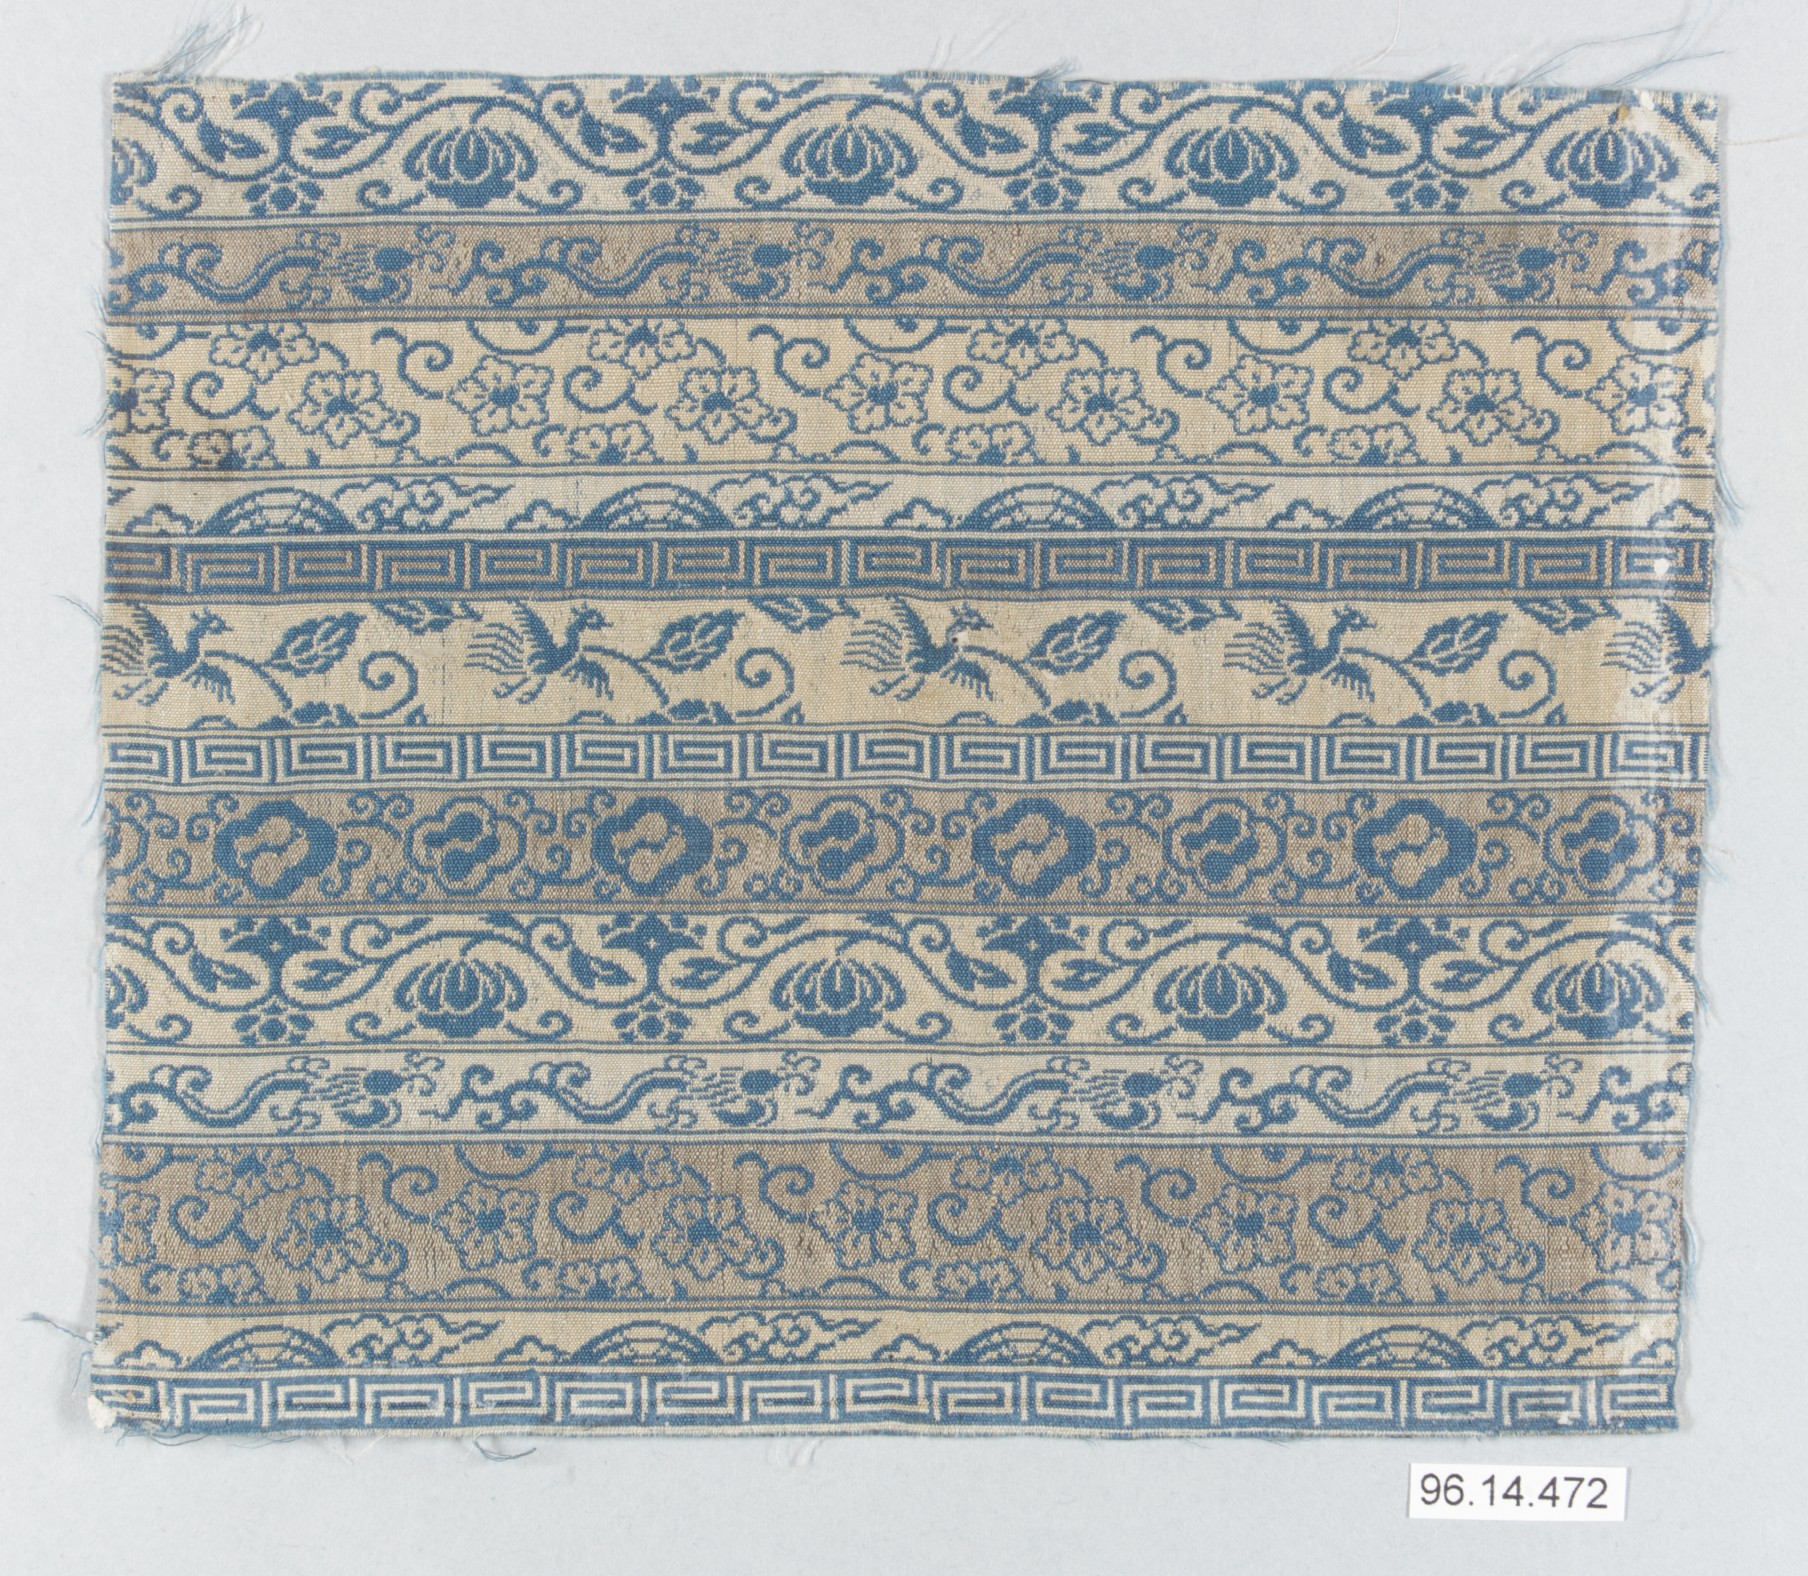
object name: piece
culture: japanese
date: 1701-1900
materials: silk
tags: mythical creatures,leaves